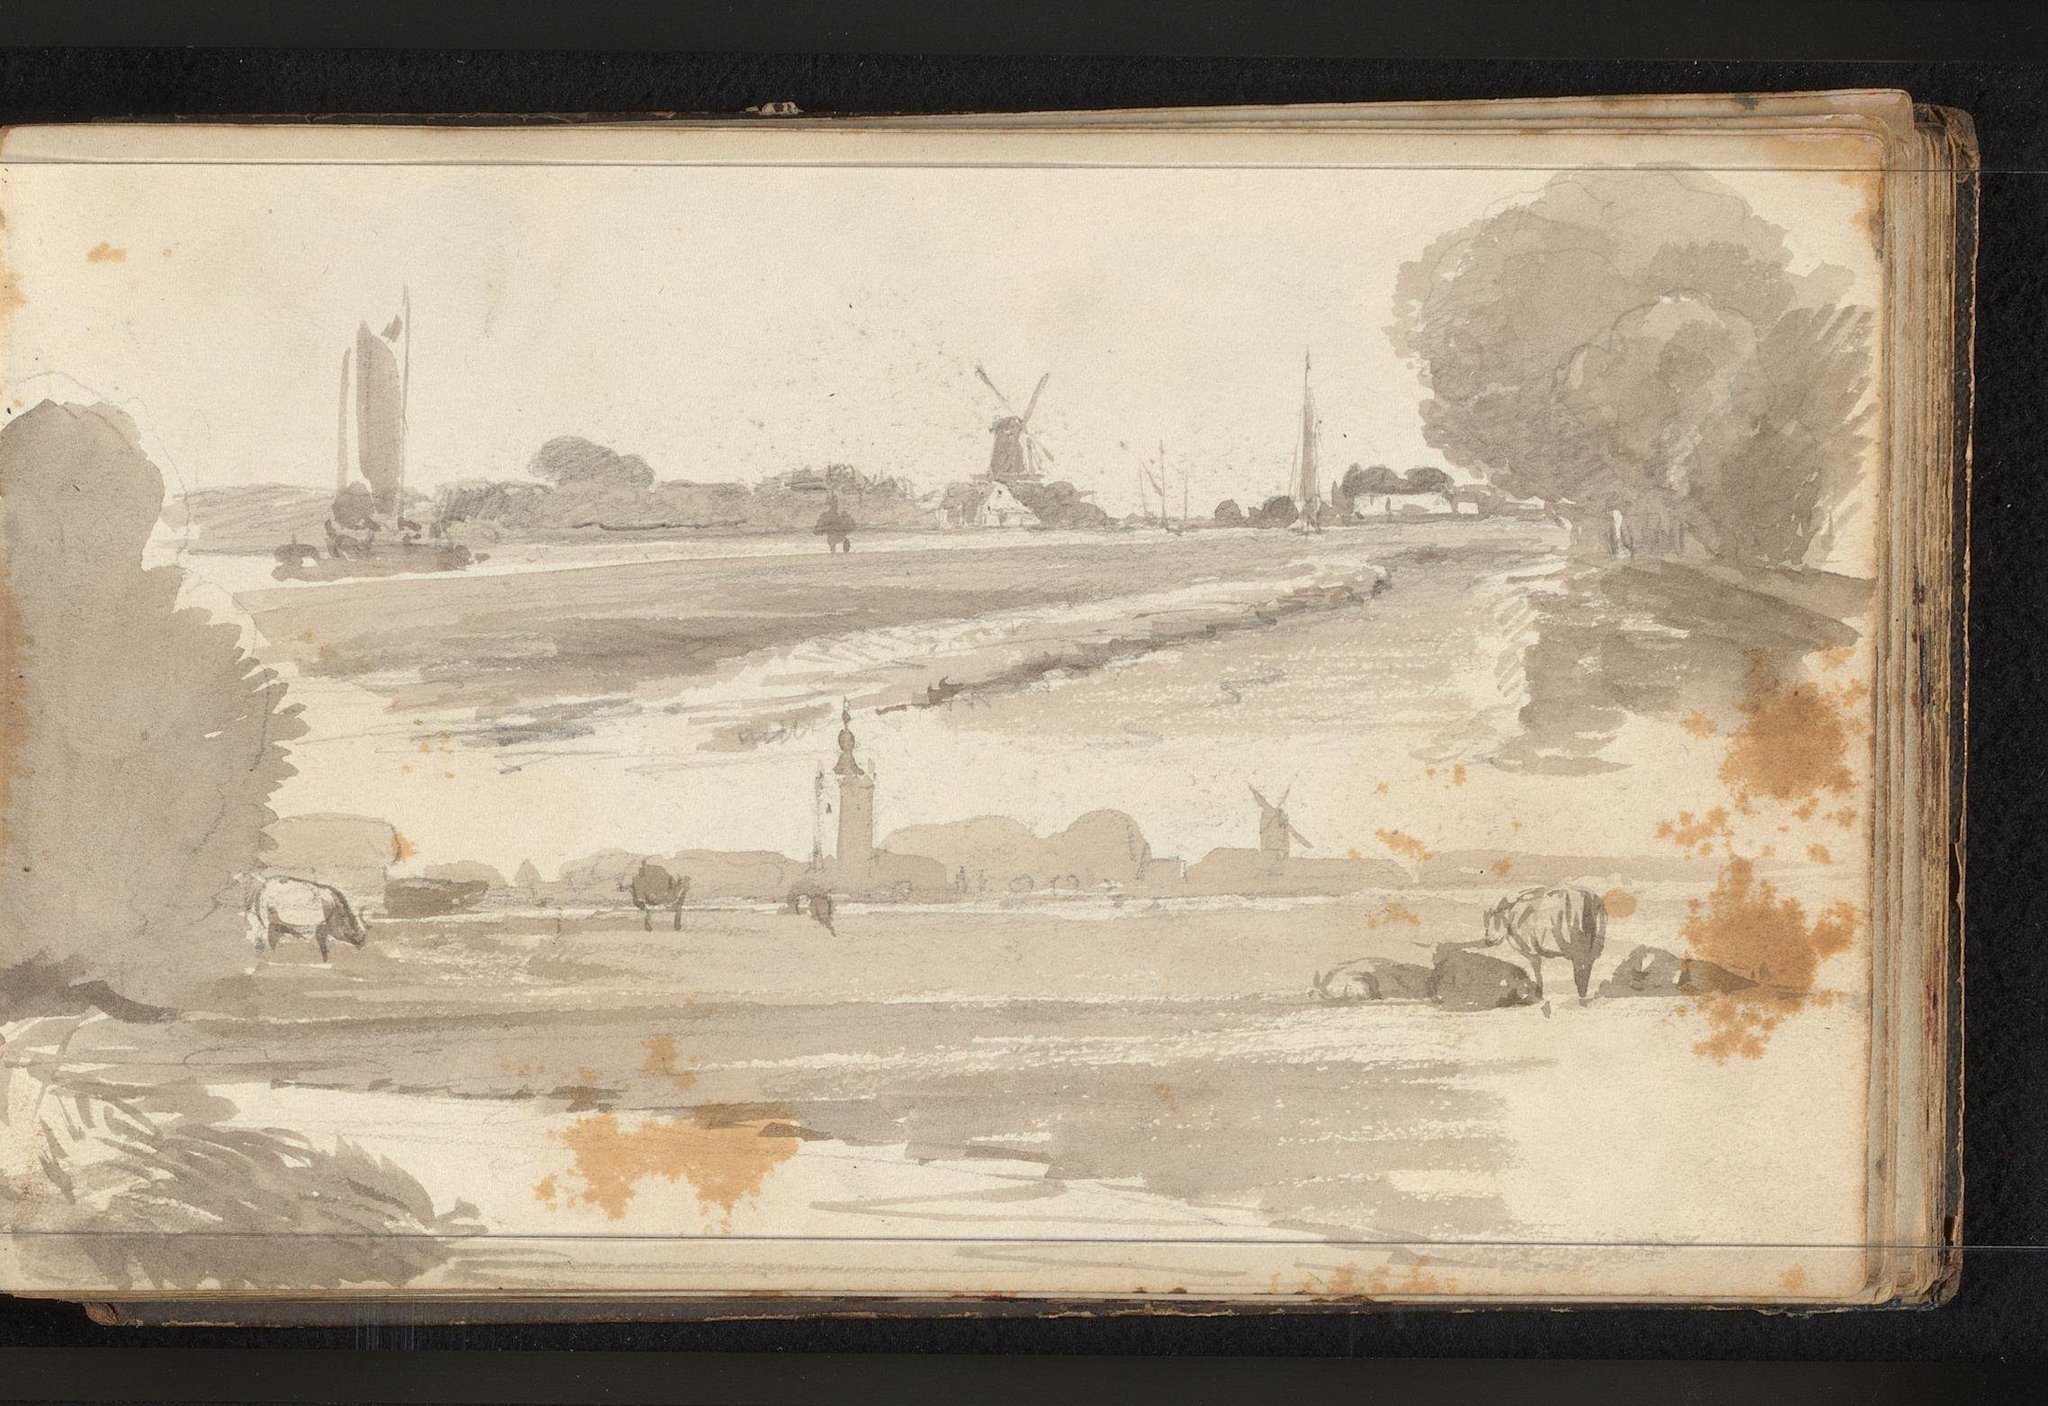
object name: sketchbook leaf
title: Twee dorpsgezichten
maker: jan bedijs tom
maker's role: draughtsman, painter, print maker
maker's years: 1813-1894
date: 1828-1894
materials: paper, pencil, watercolor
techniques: brush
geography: the hague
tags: prospect of village, silhouette of village, landscapes, meadow, pasture, artist (in general) making preliminary designs, sketching, bovine cattle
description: Pagina 36 verso uit een schetsboek met 54 bladen.